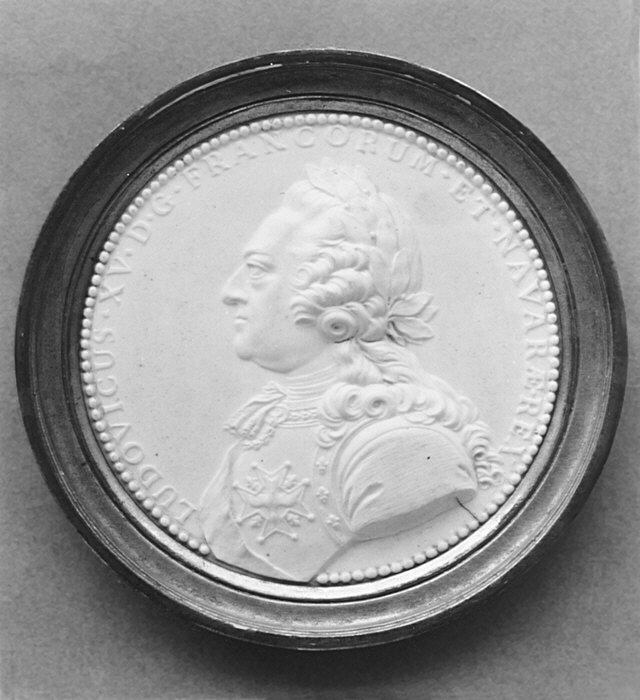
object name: medallion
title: Louis XV (1710–1774)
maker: sèvres manufactory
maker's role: manufactory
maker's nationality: french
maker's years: 1740-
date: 1701-1800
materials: biscuit, paste, porcelain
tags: men,profiles